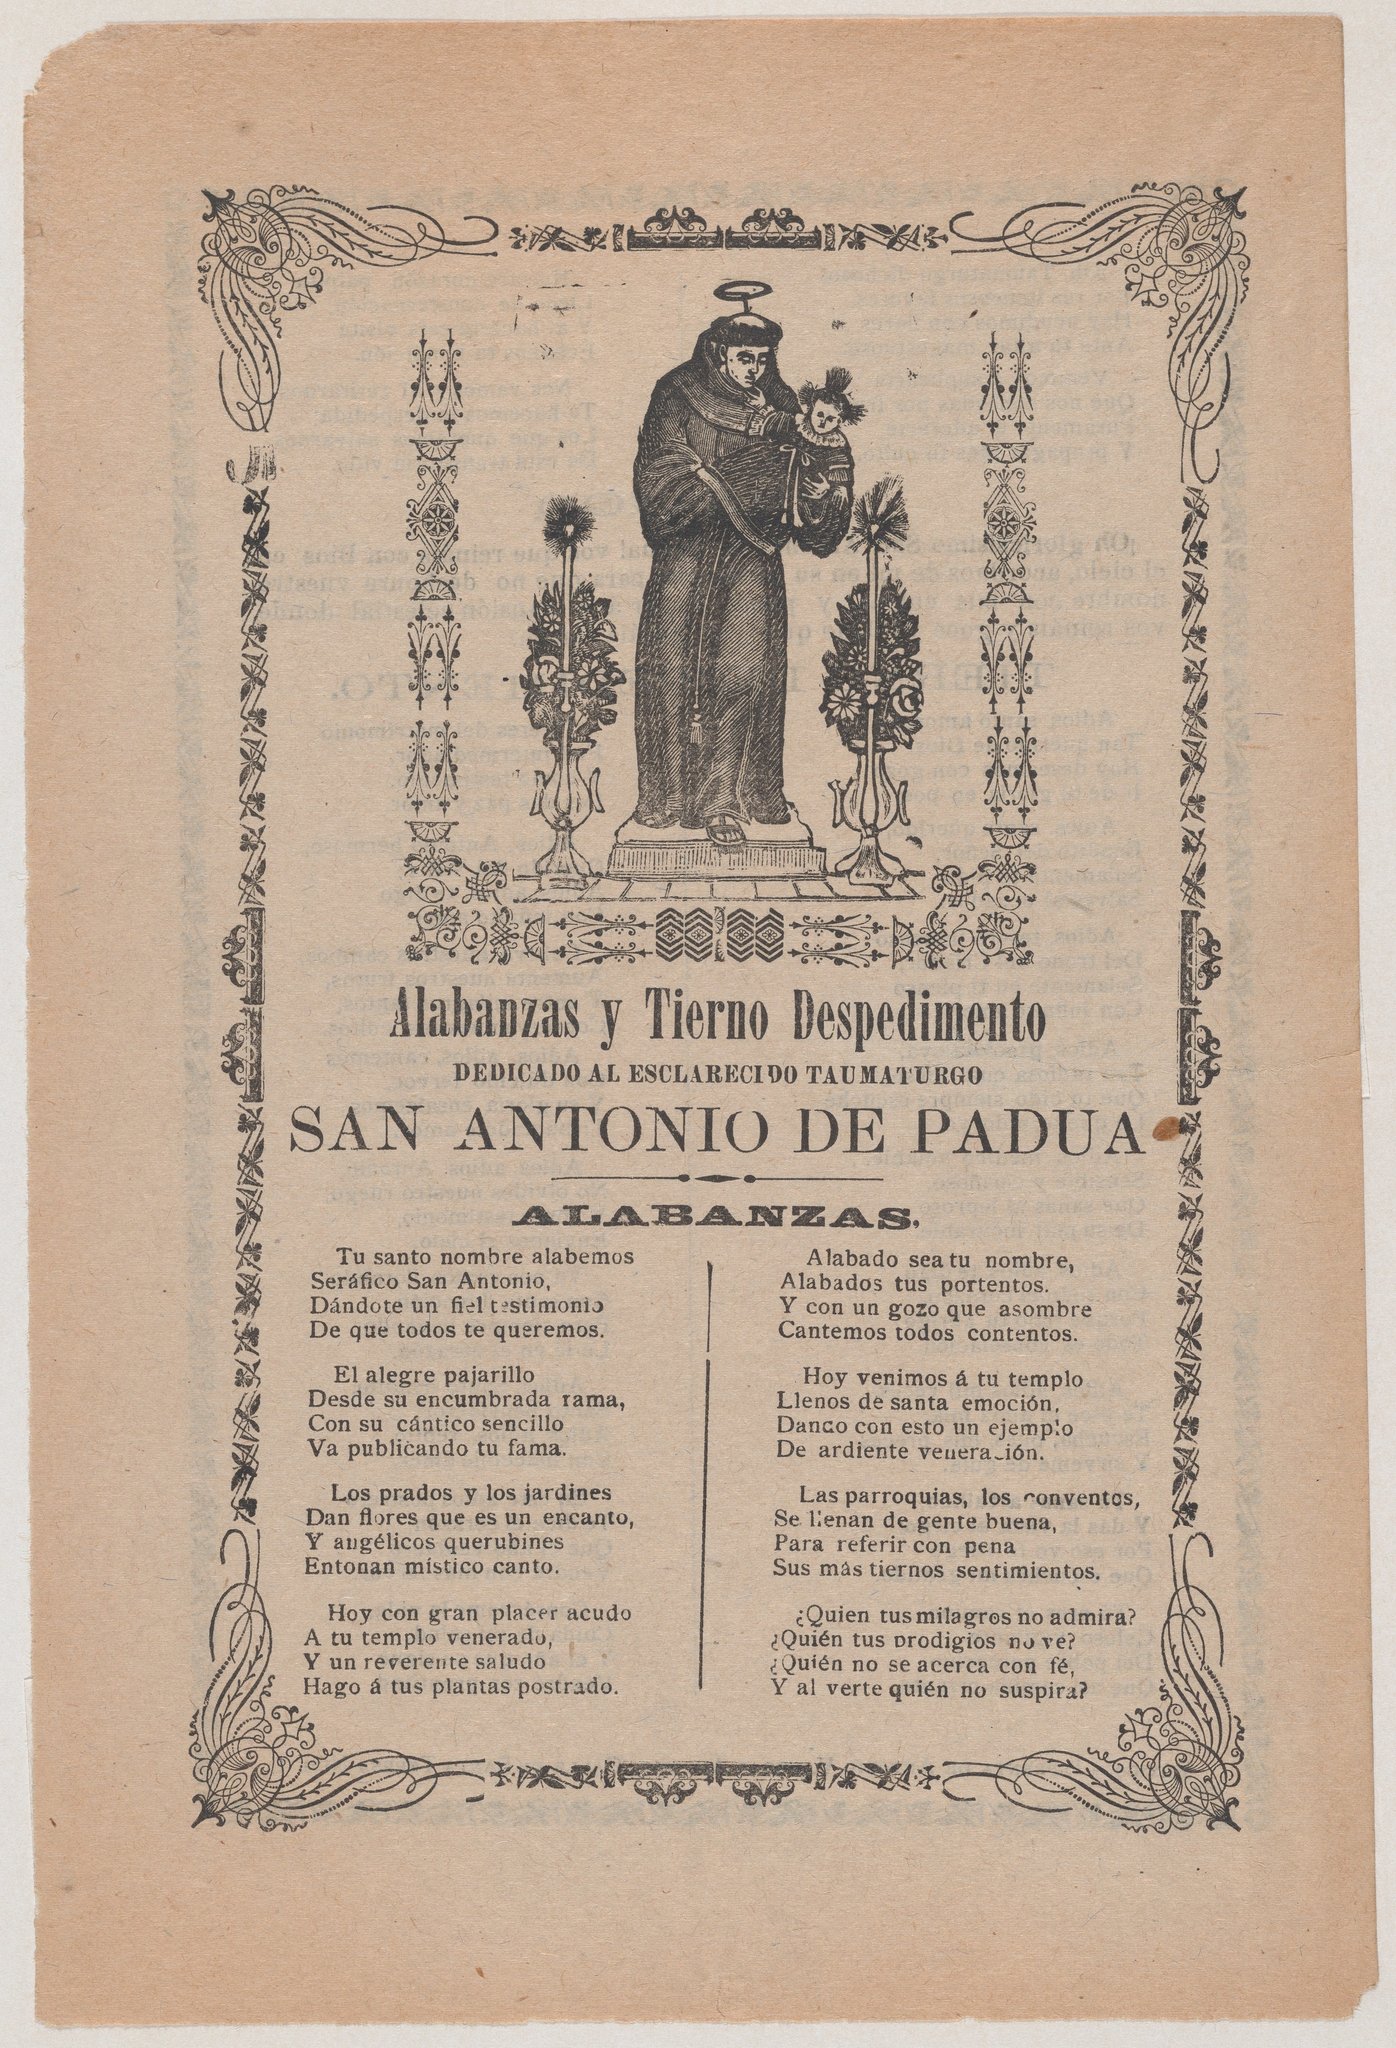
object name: print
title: Broadsheet relating to Saint Anthony of Padua who is shown holding the Christ child flanked by a candelabra with flowers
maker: josé guadalupe posada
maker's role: artist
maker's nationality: mexican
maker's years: 1852-1913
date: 1900-1913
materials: metal, paper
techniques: engraving, letterpress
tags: christ,saint anthony